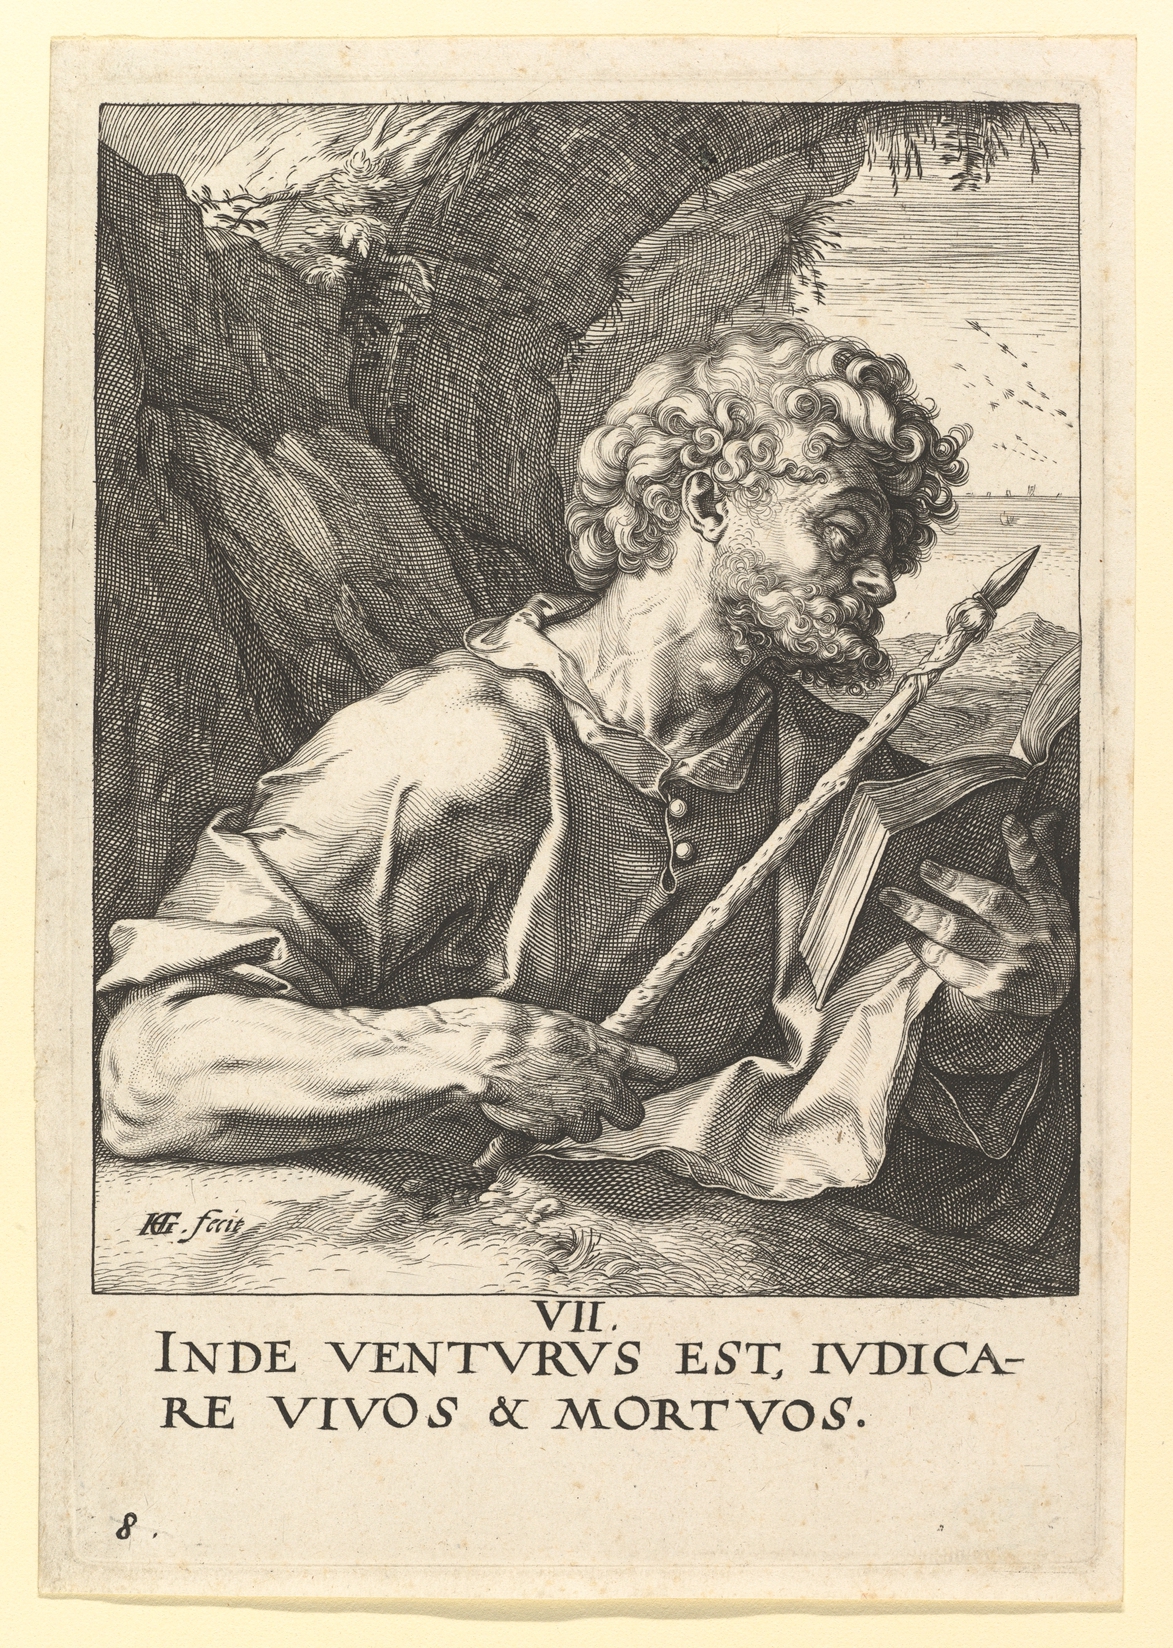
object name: print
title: St. Thomas, from "Christ, the Apostles and St. Paul with the Creed"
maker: hendrick goltzius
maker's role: artist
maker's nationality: netherlandish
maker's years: 1558-1617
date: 1589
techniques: engraving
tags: books,men,reading,saints